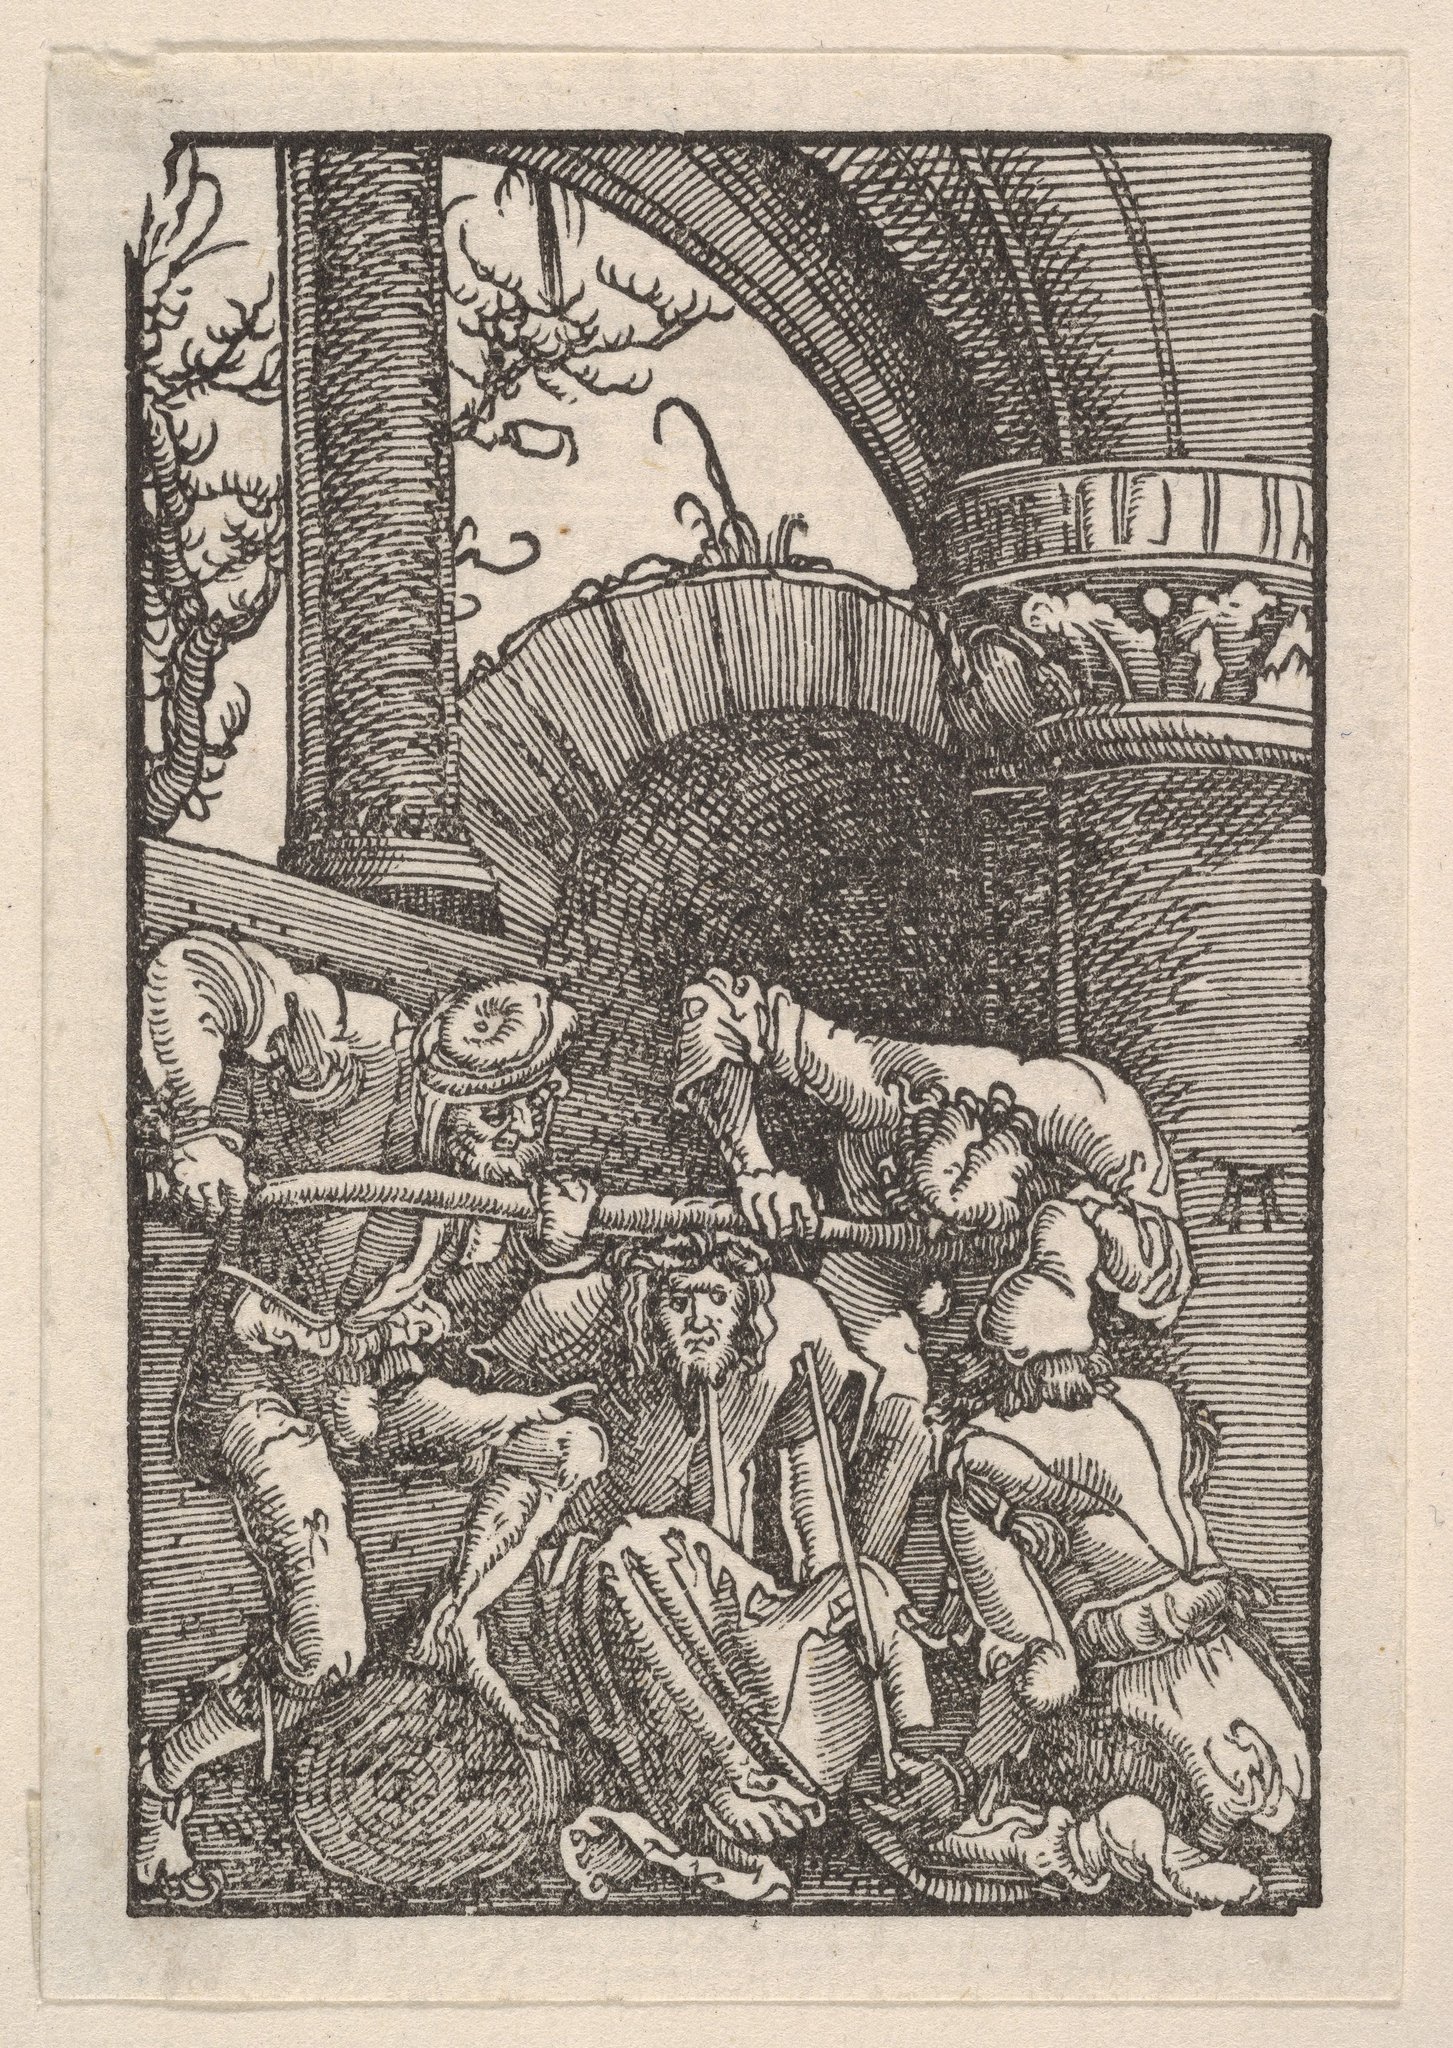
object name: print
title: The Crowning with Thorns, from "The Fall and Salvation of Mankind Through the Life and Passion of Christ"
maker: albrecht altdorfer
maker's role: artist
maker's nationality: german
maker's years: 1480-1538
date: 1513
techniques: woodcut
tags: suffering,men,christ,punishment